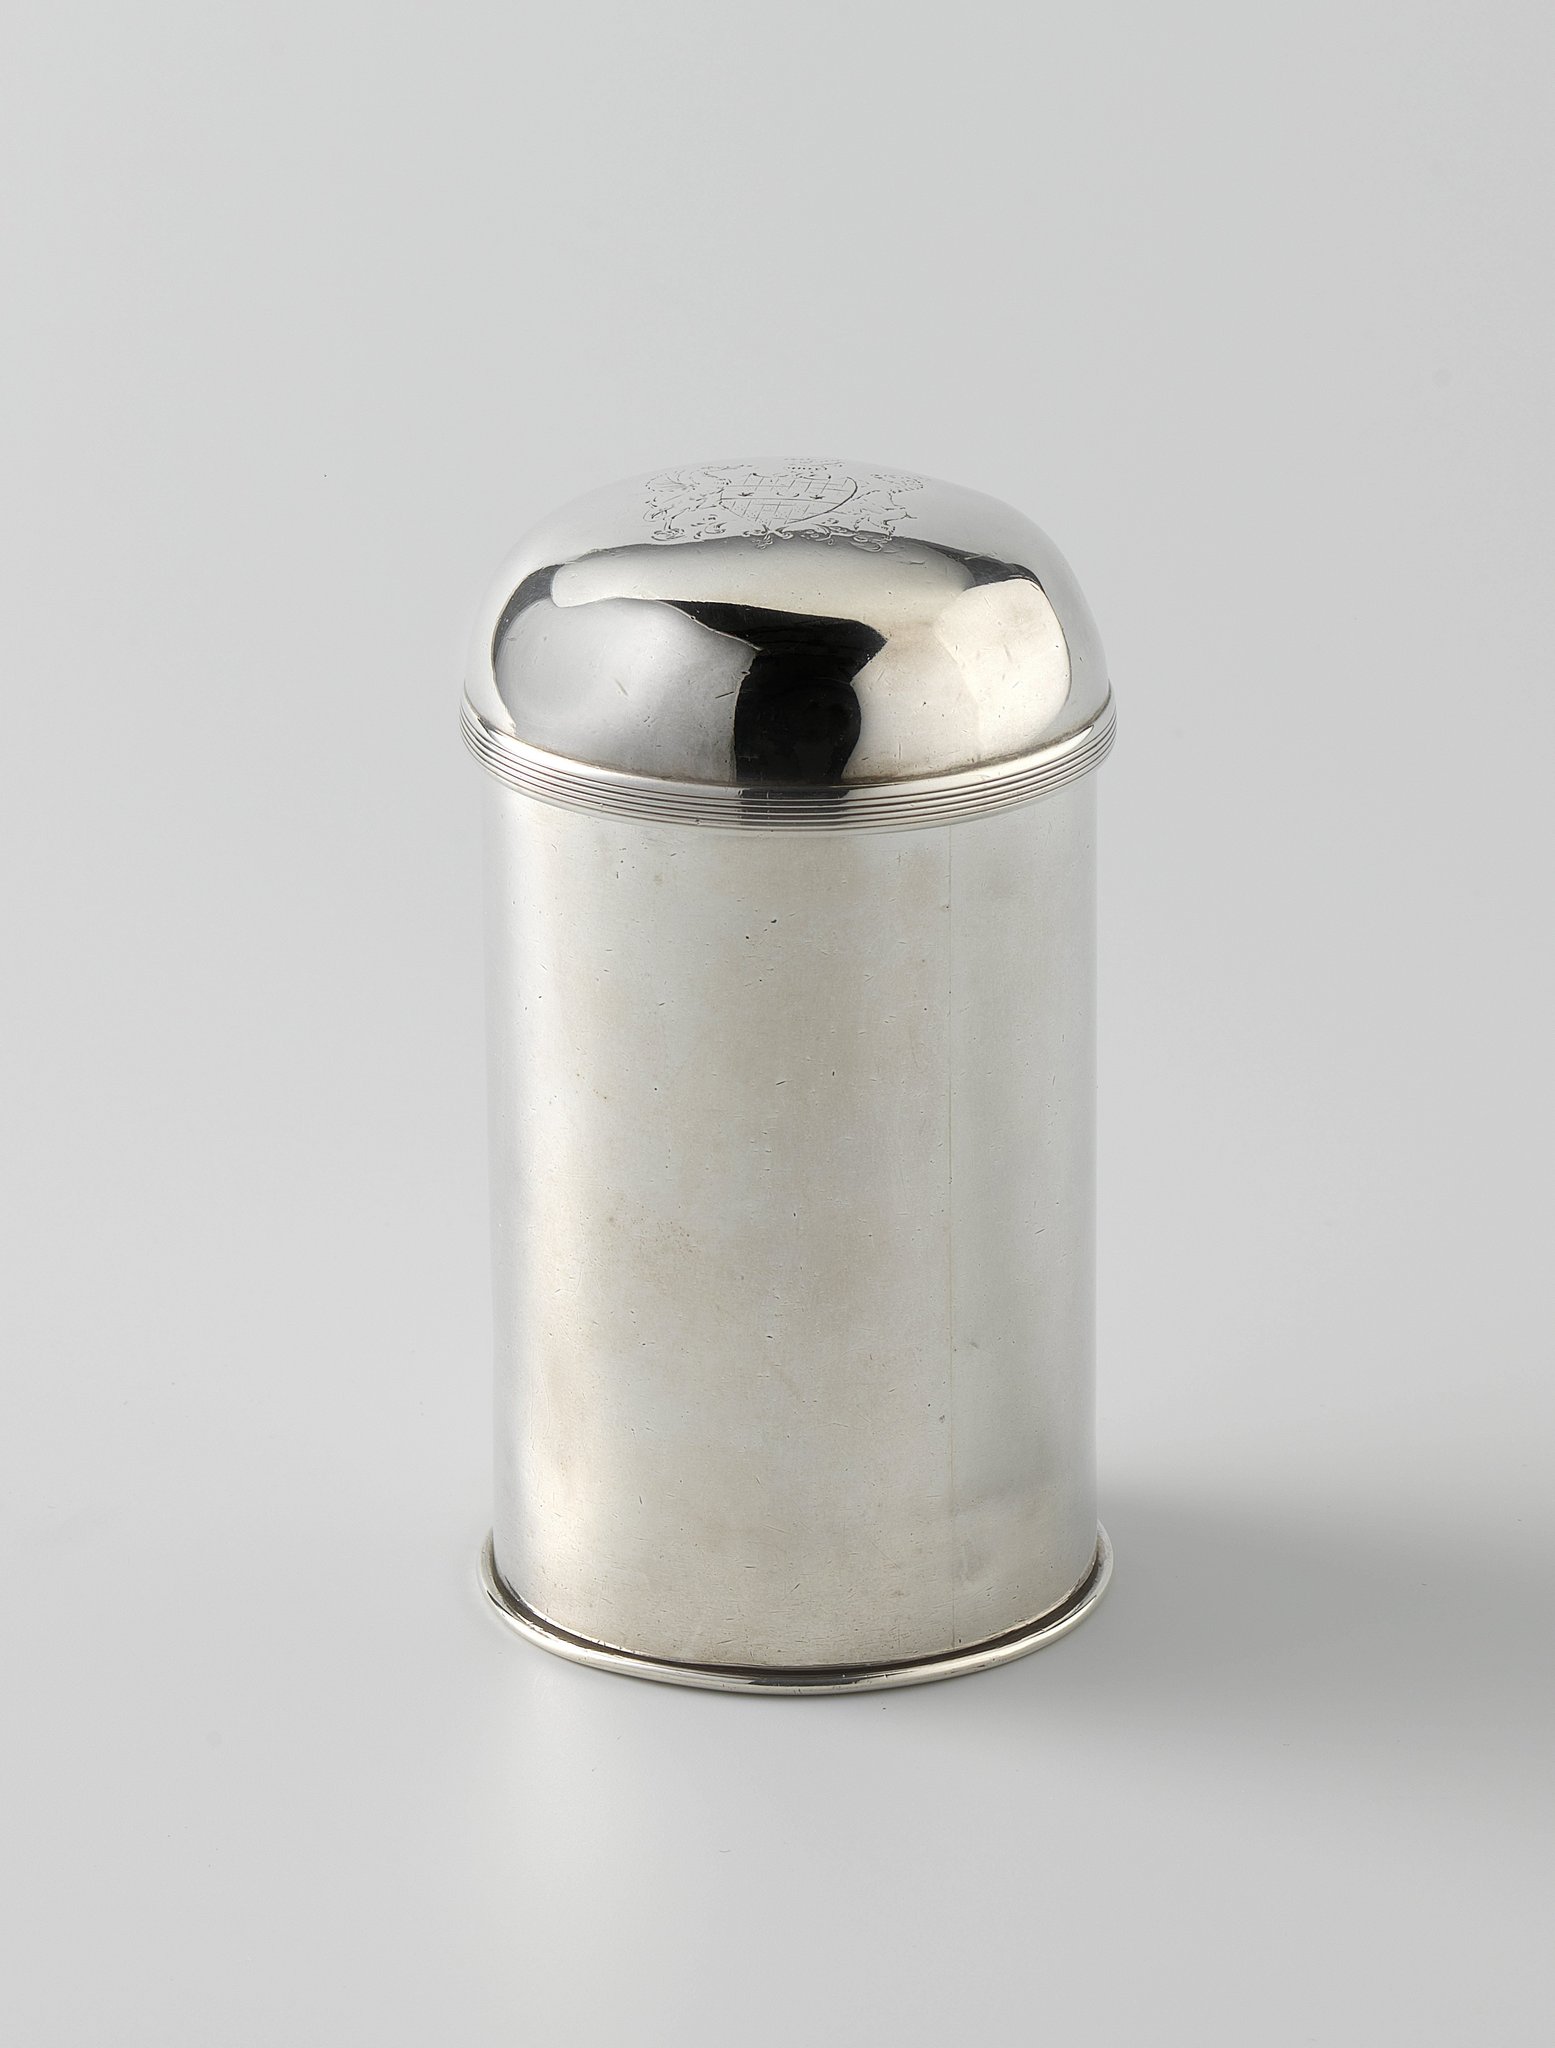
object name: strooibus, strooier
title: Caster with cover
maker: diederik lodewijk bennewitz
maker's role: silversmith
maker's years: 1763-1826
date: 1806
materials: silver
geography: amsterdam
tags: armorial bearing, heraldry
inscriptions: alloy mark, maker's mark, town mark, date letter: ‘X’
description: De gladde, cilindrische bus heeft een afschroefbare bodem waarvan de rand even uitsteekt. In de bolle bovenzijde zijn spiraalsgewijs ronde strooigaatjes aangebracht. Er past een bol deksel op, waarvan de onderzijde is versierd met een filetrand. Op het deksel is het wapen Clifford met het helmteken en schildhouders gegraveerd.